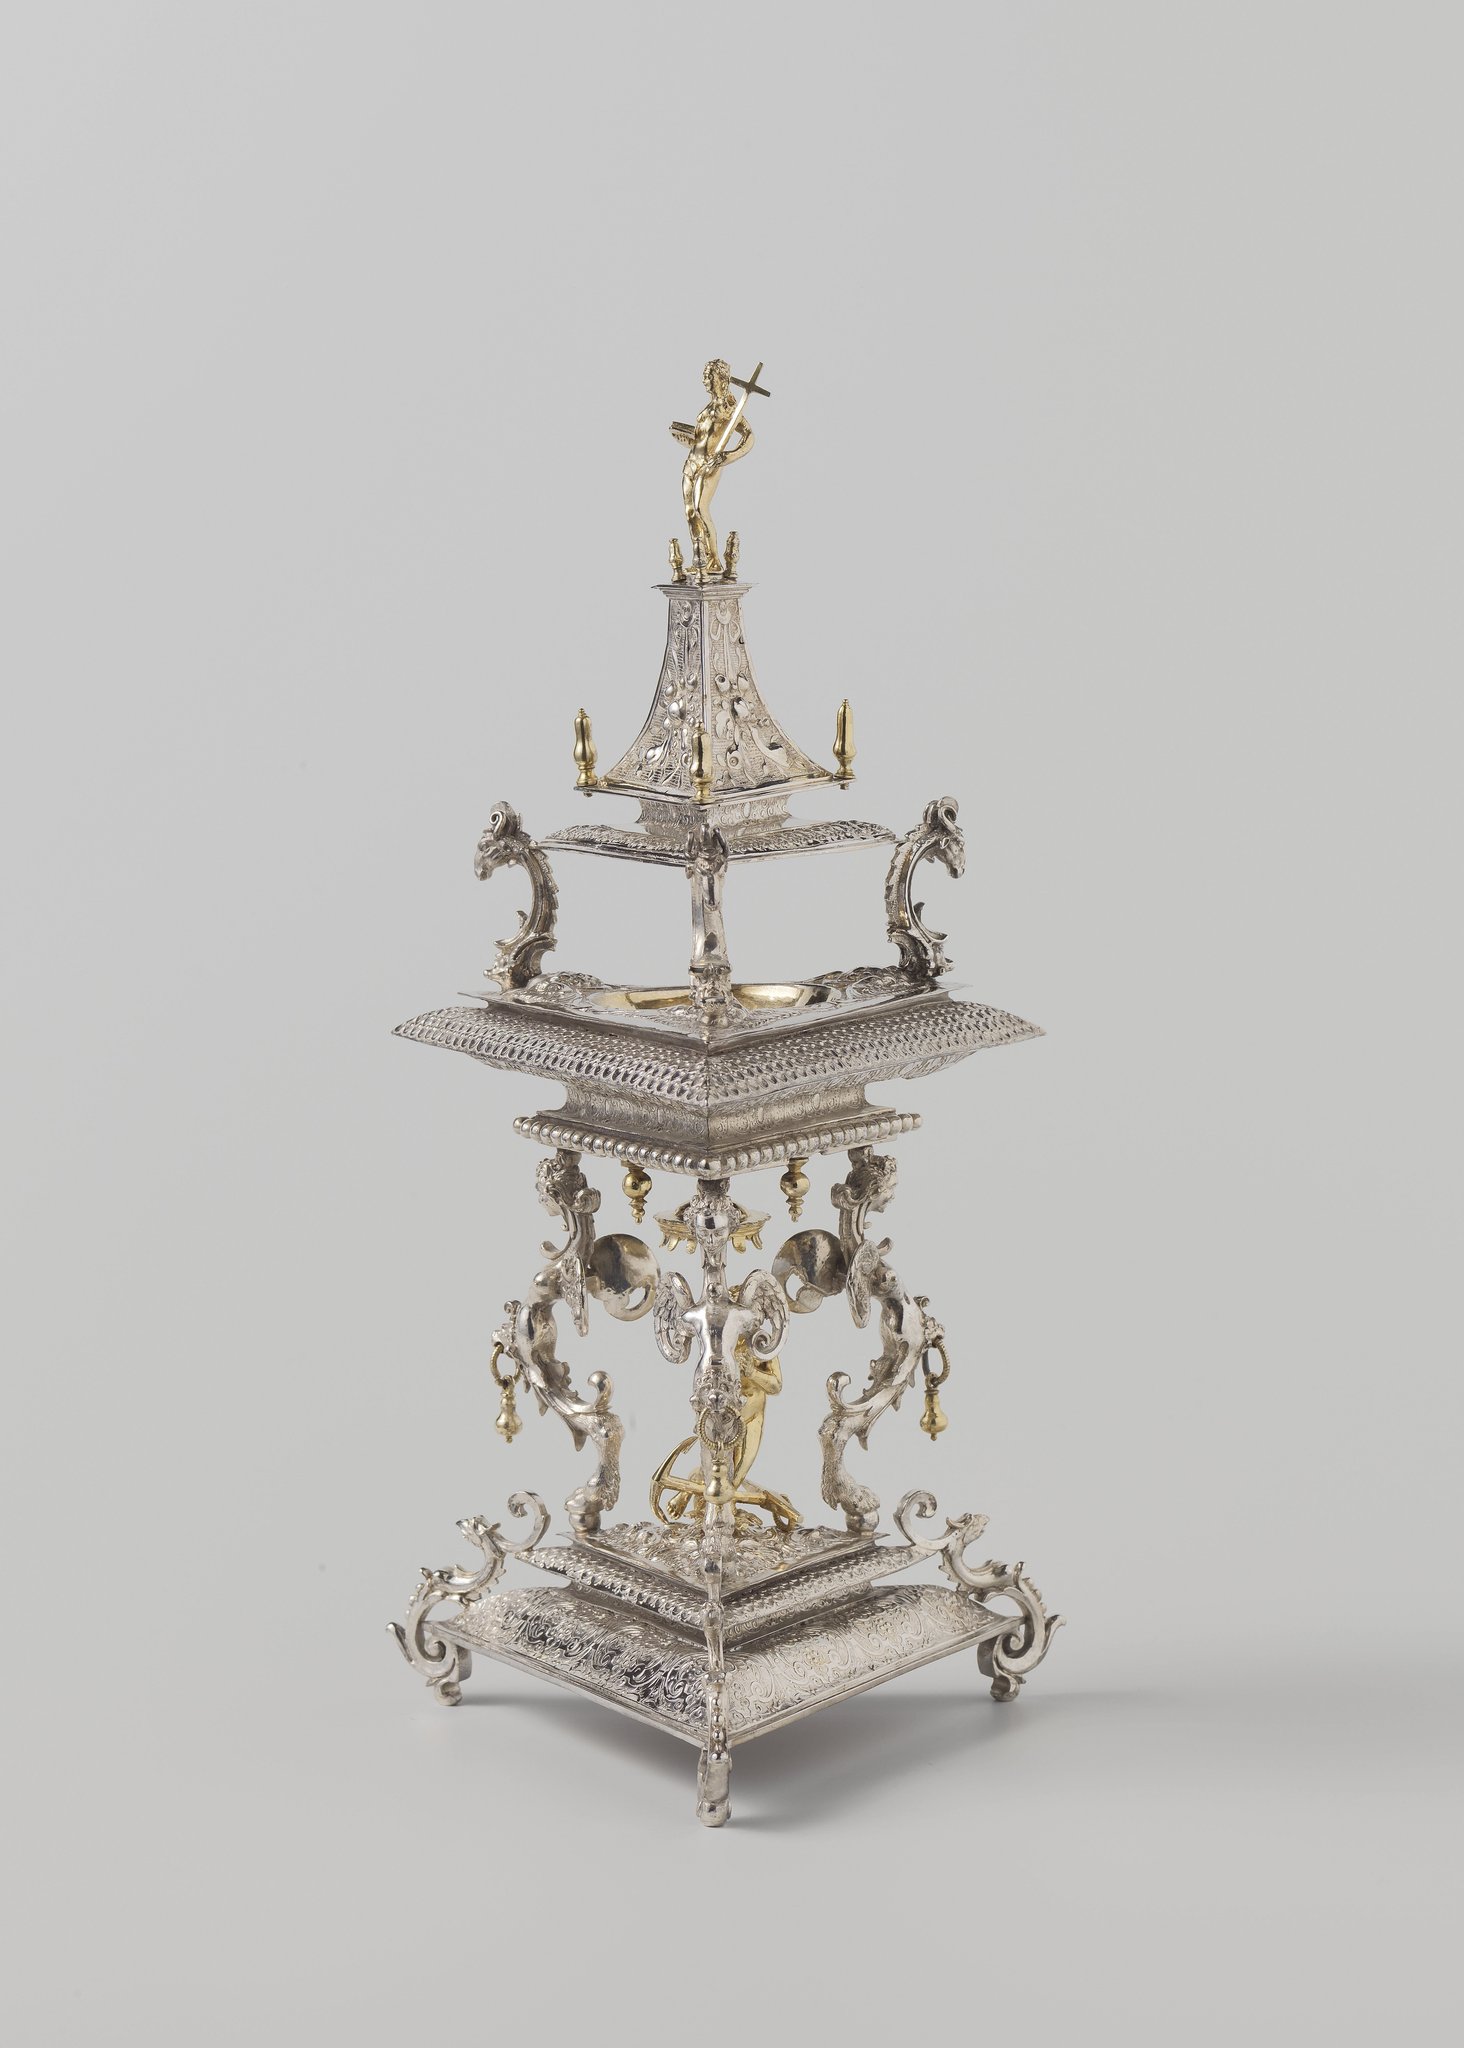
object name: opzetstuk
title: Opzetstuk van een driehoekig zoutvat, bekroond door de personificatie van de Hoop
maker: Anonymous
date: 1618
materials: silver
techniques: gilding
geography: amsterdam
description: Salt with superstructure. Silver, partly gilded. Amsterdam, 1618, unknown maker. Purchased with the support of the Rembrandt Association, the Rijksmuseum Foundation and the Ministry of Science, Public Health and Culture, 1988.